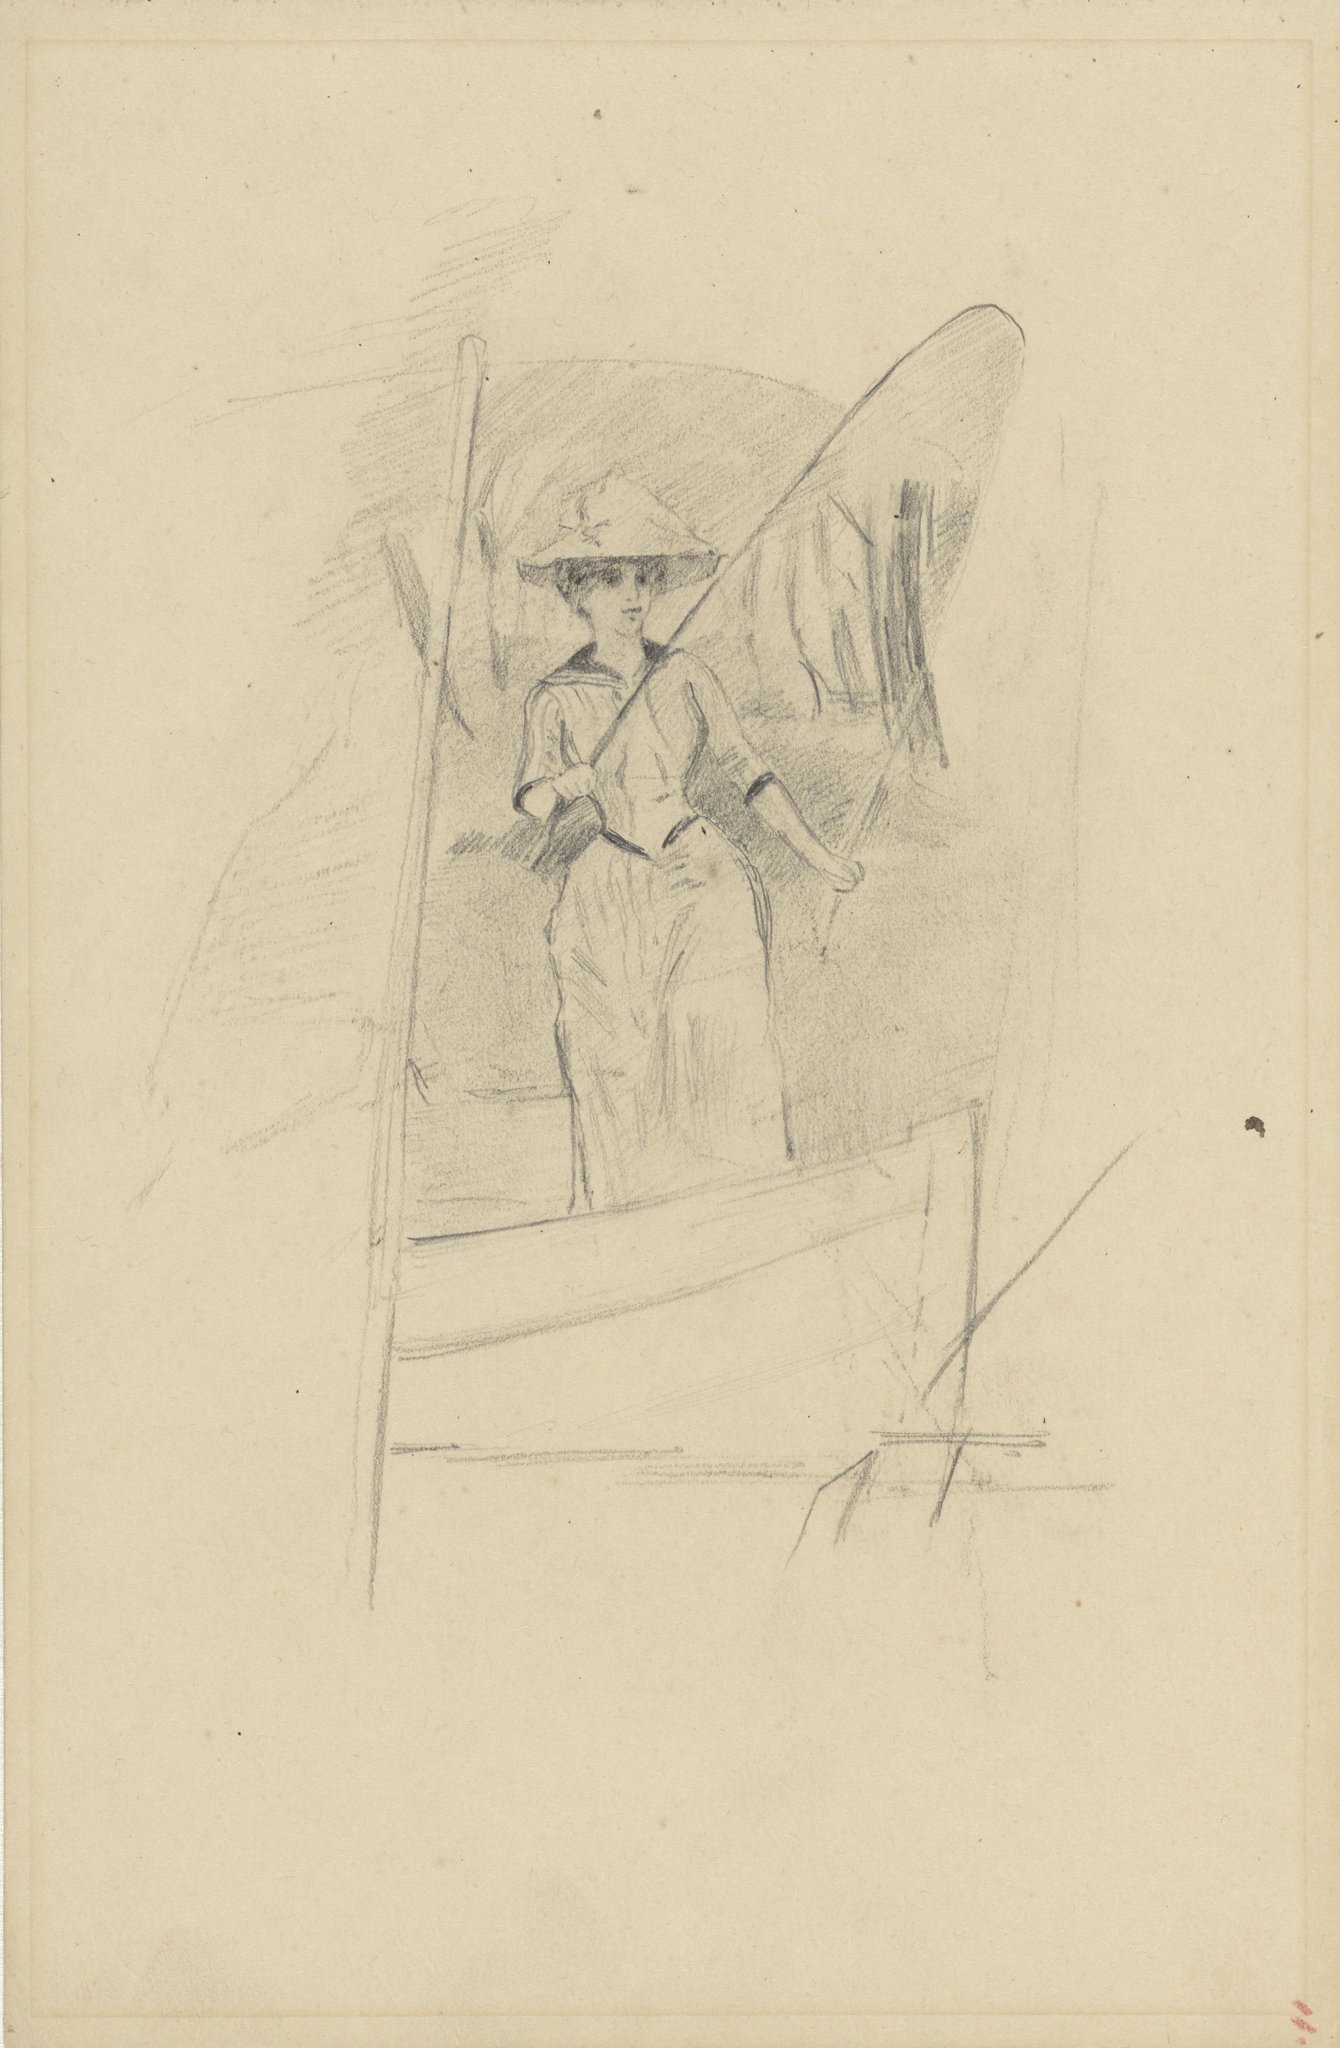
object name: drawing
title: Vrouw met een hengel in een bootje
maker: jozef israëls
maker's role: draughtsman, painter, print maker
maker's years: 1824-1911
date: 1834-1911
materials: chalk, paper, pencil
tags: angling